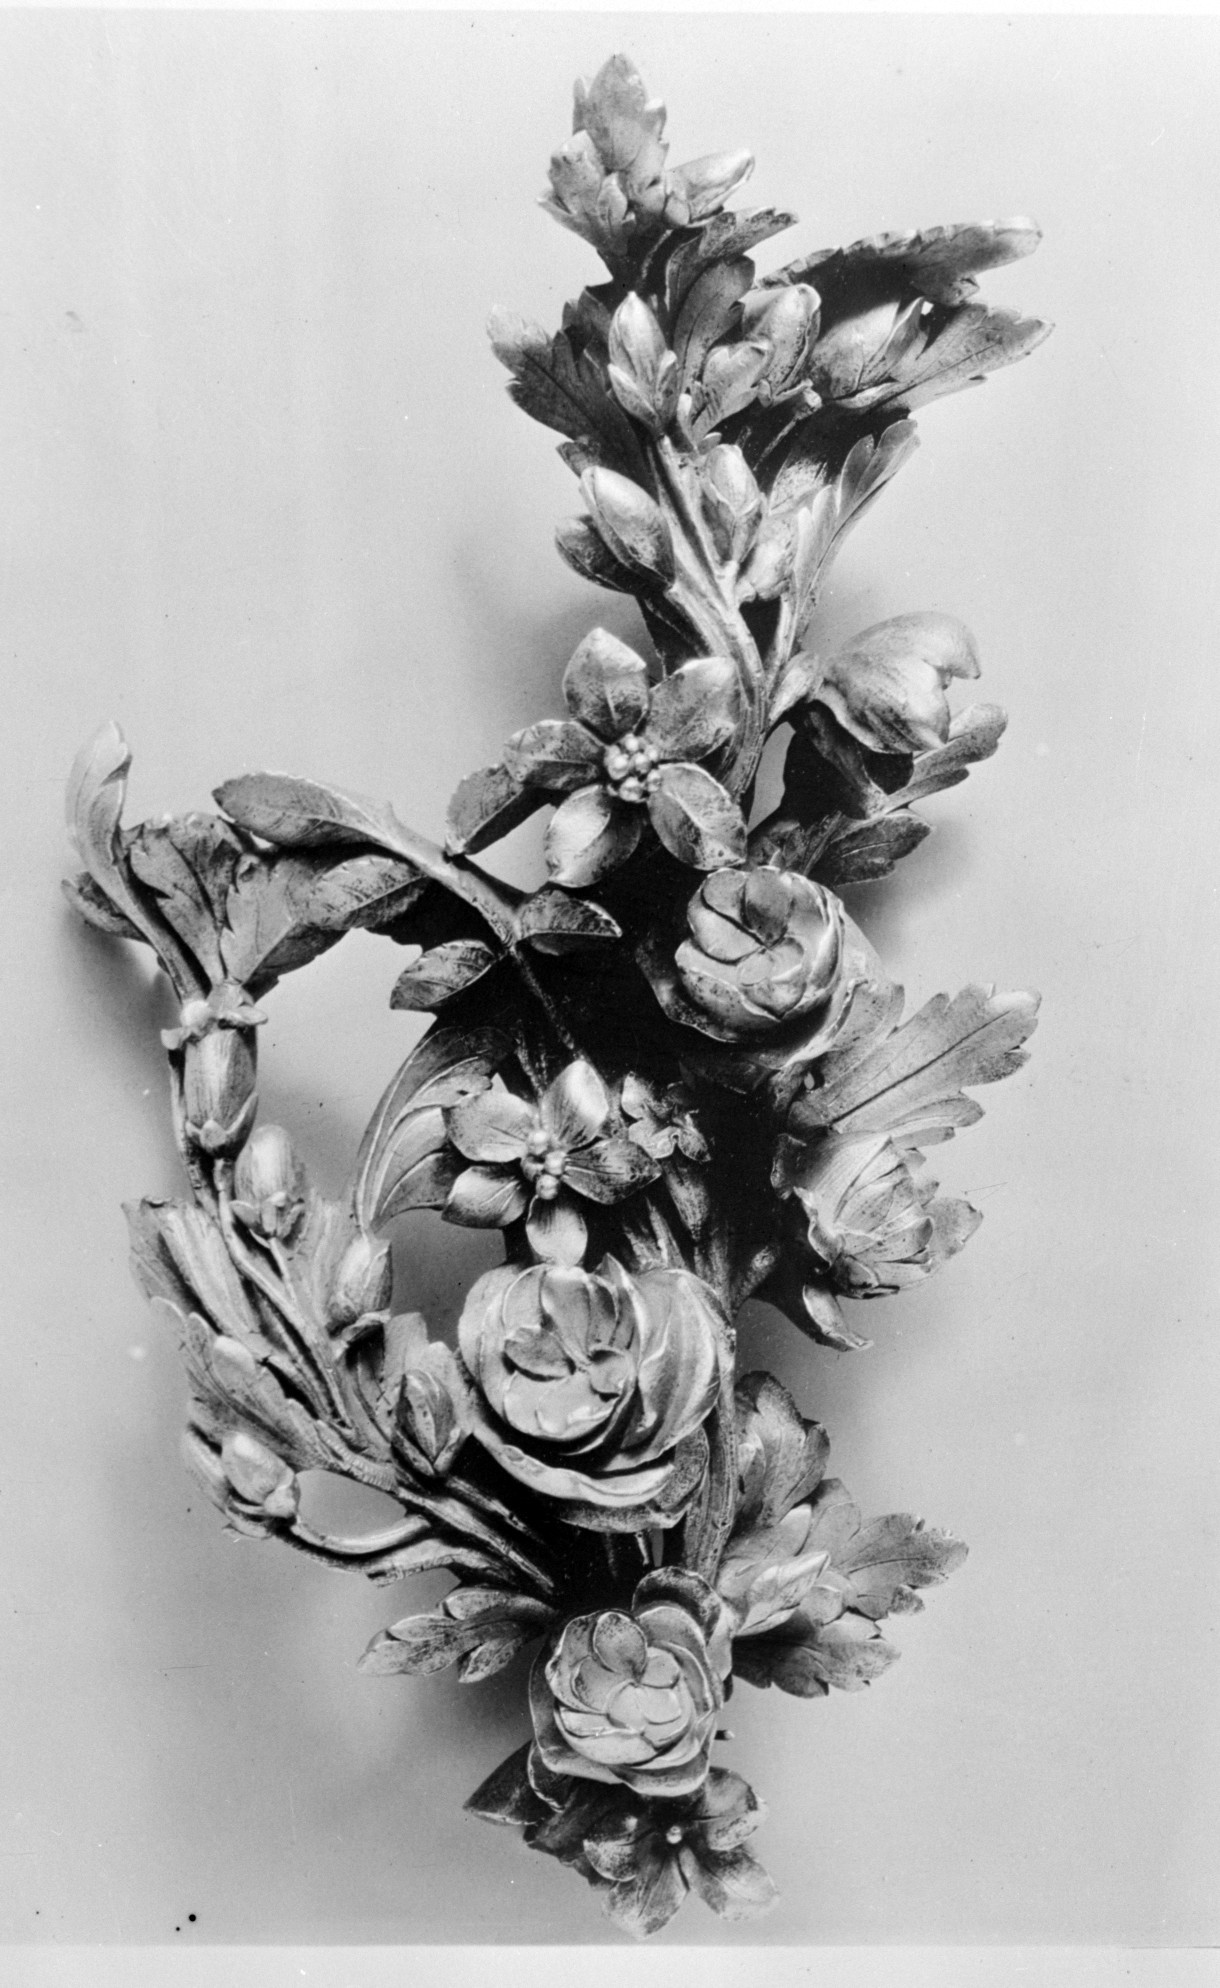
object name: chute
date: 1701-1800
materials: gilt bronze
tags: flowers,leaves